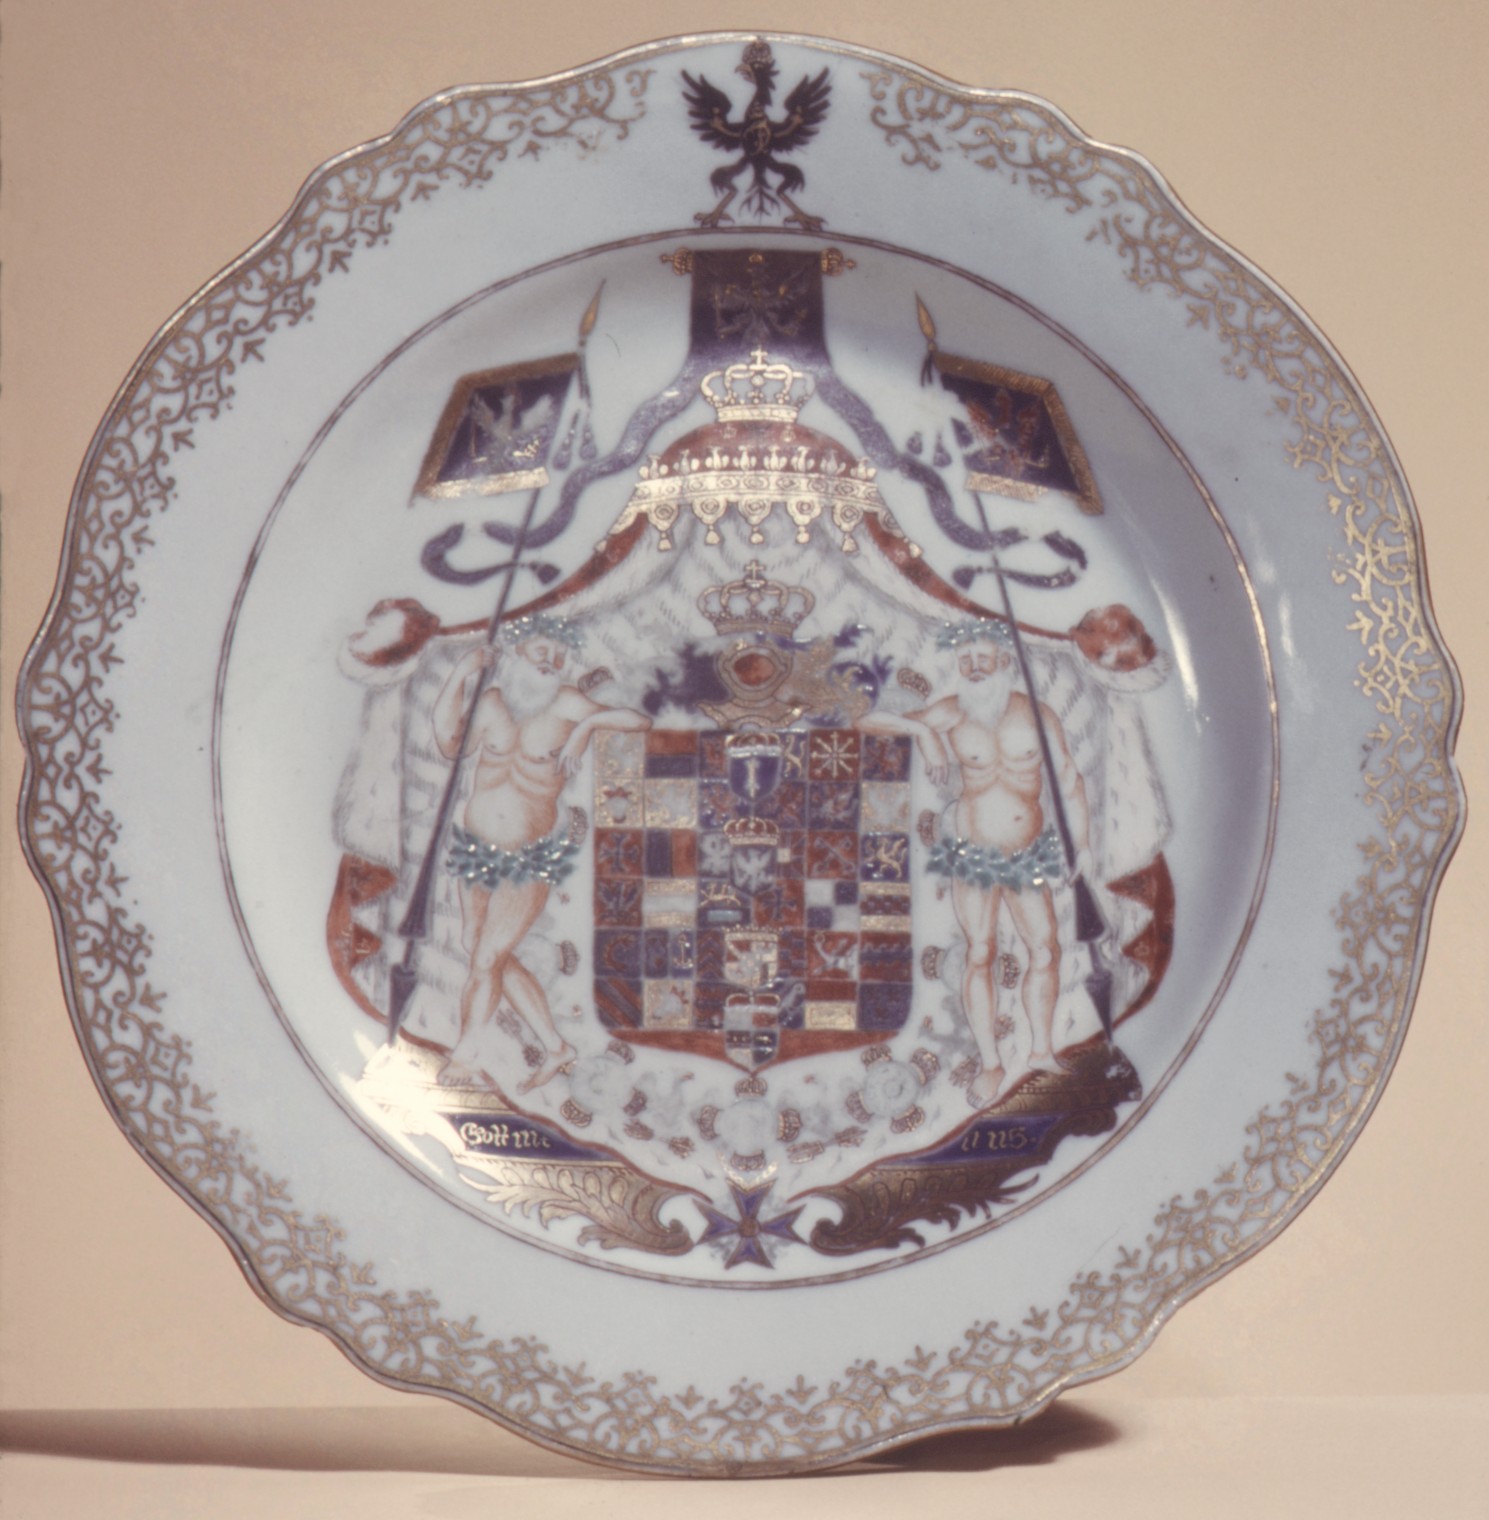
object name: plate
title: Plate (one of two)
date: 1750-1755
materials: hard paste porcelain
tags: men,coat of arms